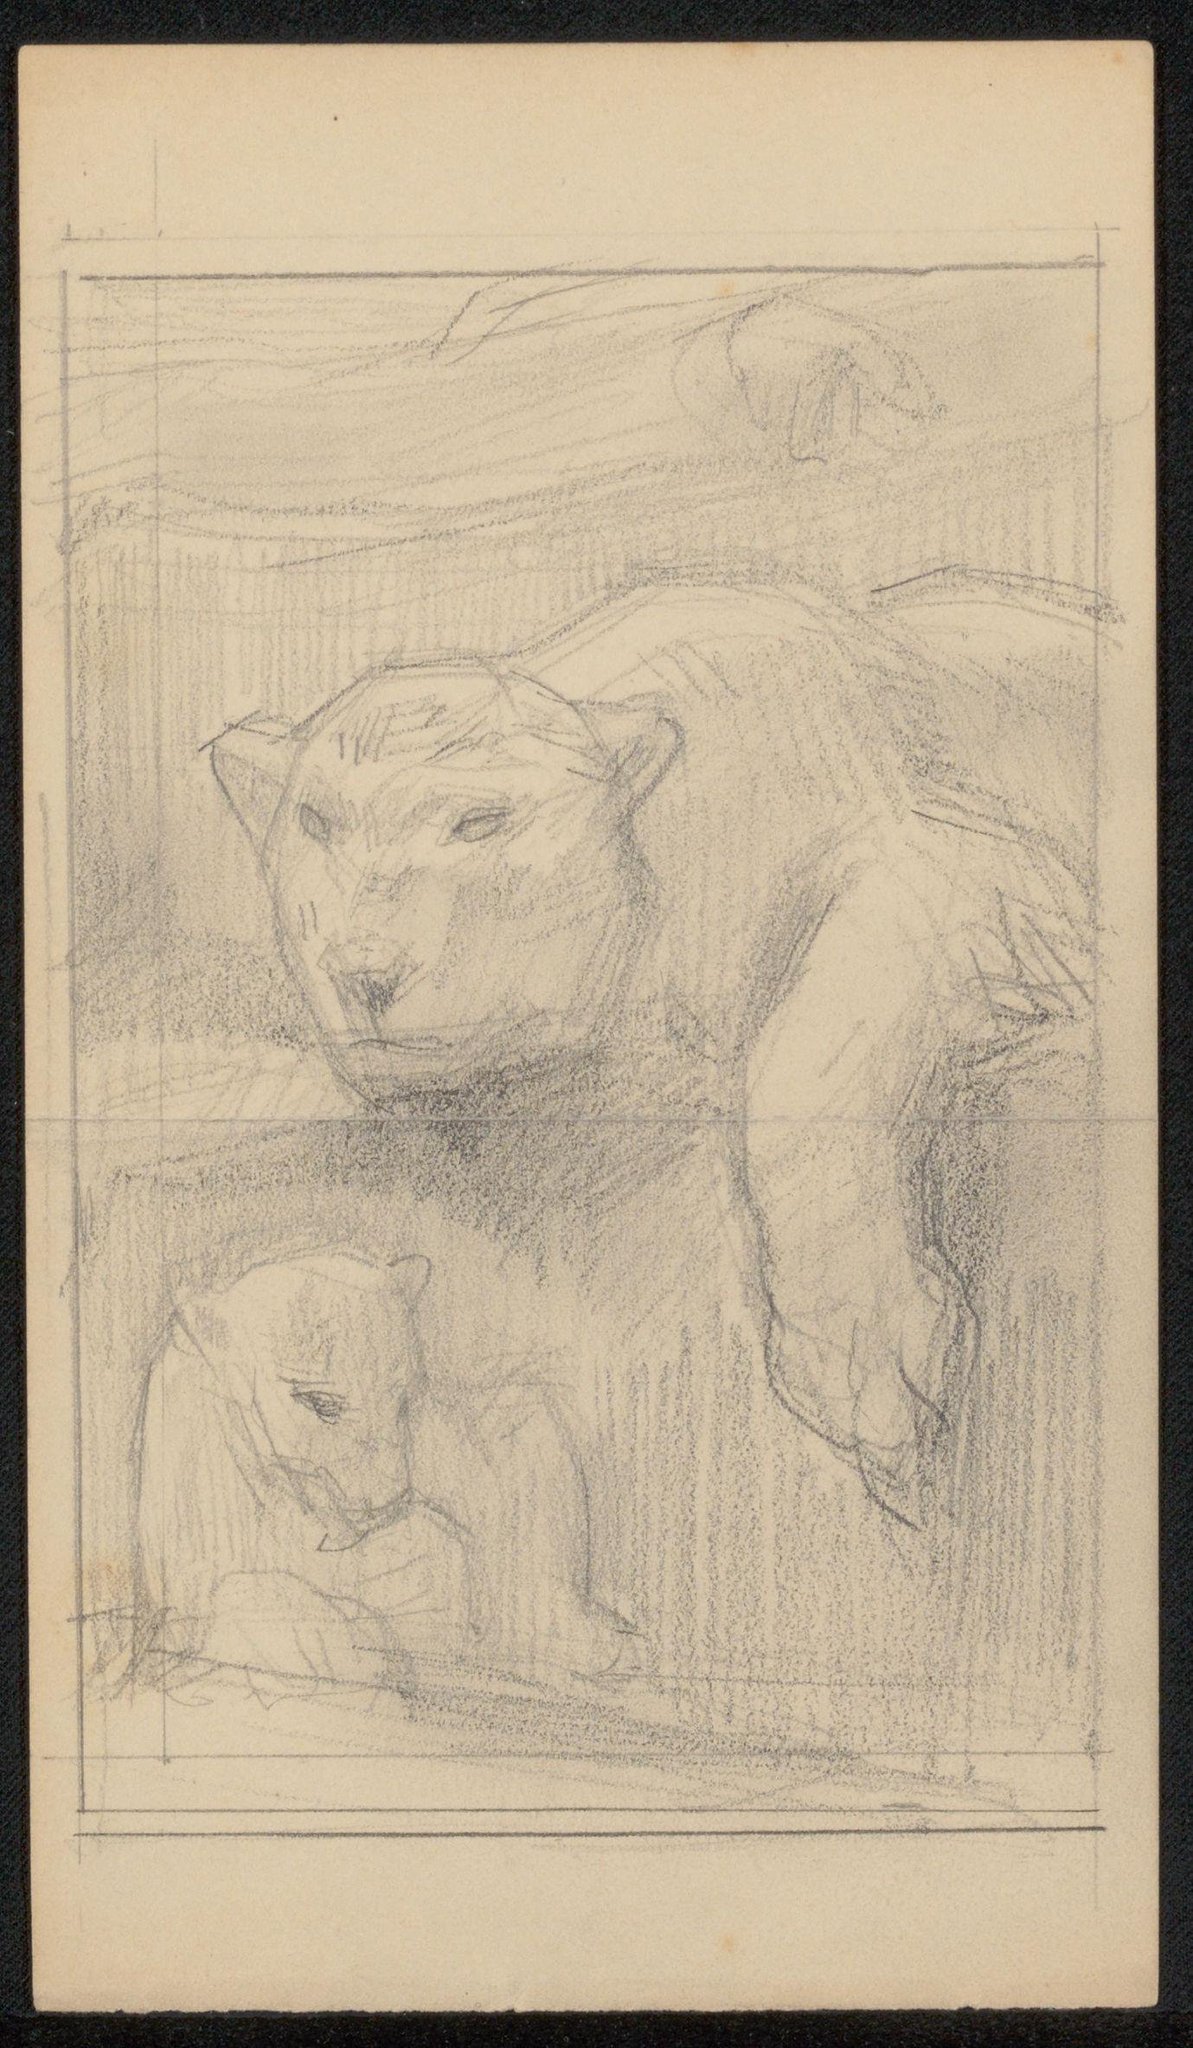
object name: drawing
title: Tekening uit archief Jan Veth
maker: august allebé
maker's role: draughtsman, print maker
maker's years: 1838-1927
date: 1848-1927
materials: paper, pencil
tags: dordrecht, painter, print maker, draughtsman, designer, jan veth, beasts of prey, predatory animals: polar bear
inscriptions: collector's mark: ‘RPK’